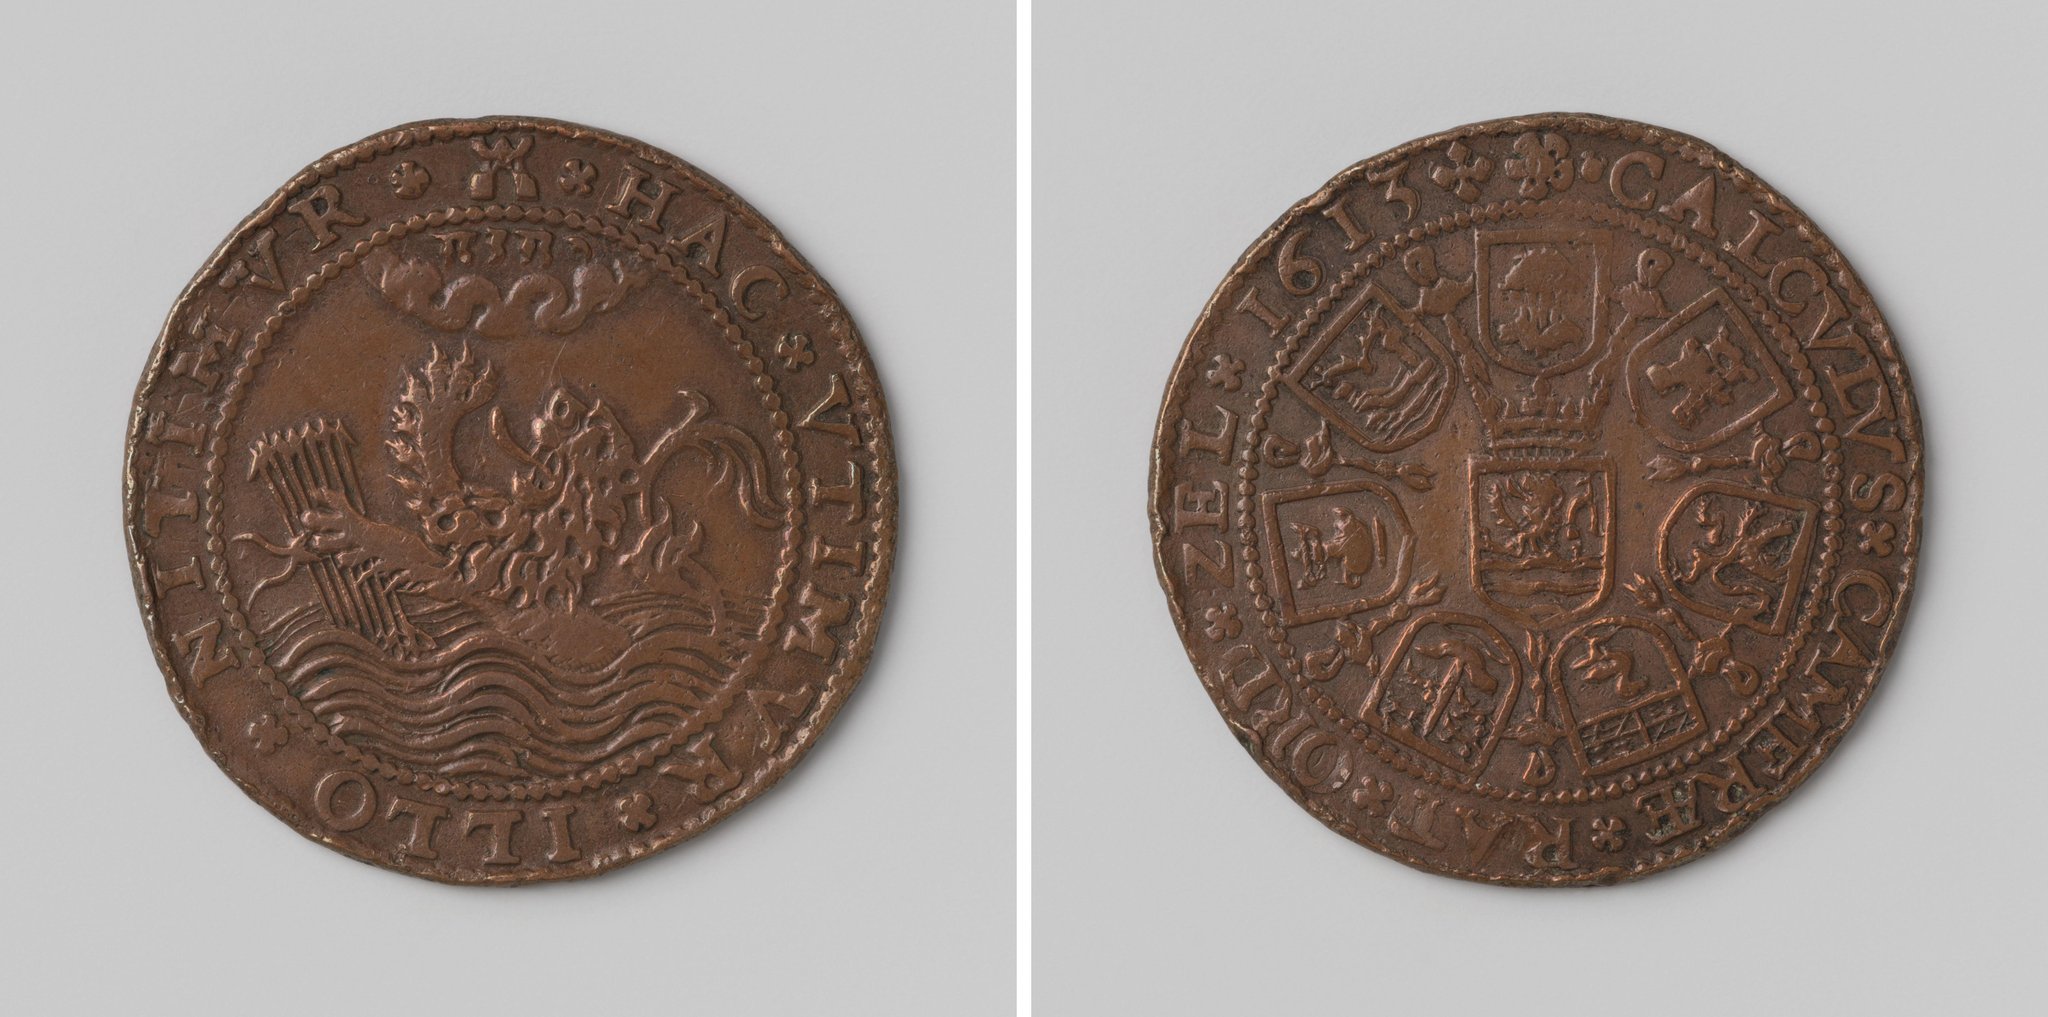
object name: jeton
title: Oproer te Utrecht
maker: Anonymous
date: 1613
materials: copper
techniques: striking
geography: middelburg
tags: zeeland, utrecht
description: Koperen penning. Voorzijde: leeuw met bundel van zeven pijlen in klauw, tot zijn middel staande in water beschenen door hemellicht, met daarin naam Jehovah in Hebreeuws schrift binnen omschrift. Keerzijde: gekroond wapenschild, omgeven door rand van zeven met lint samengebonden wapenschilden binnen omschrift